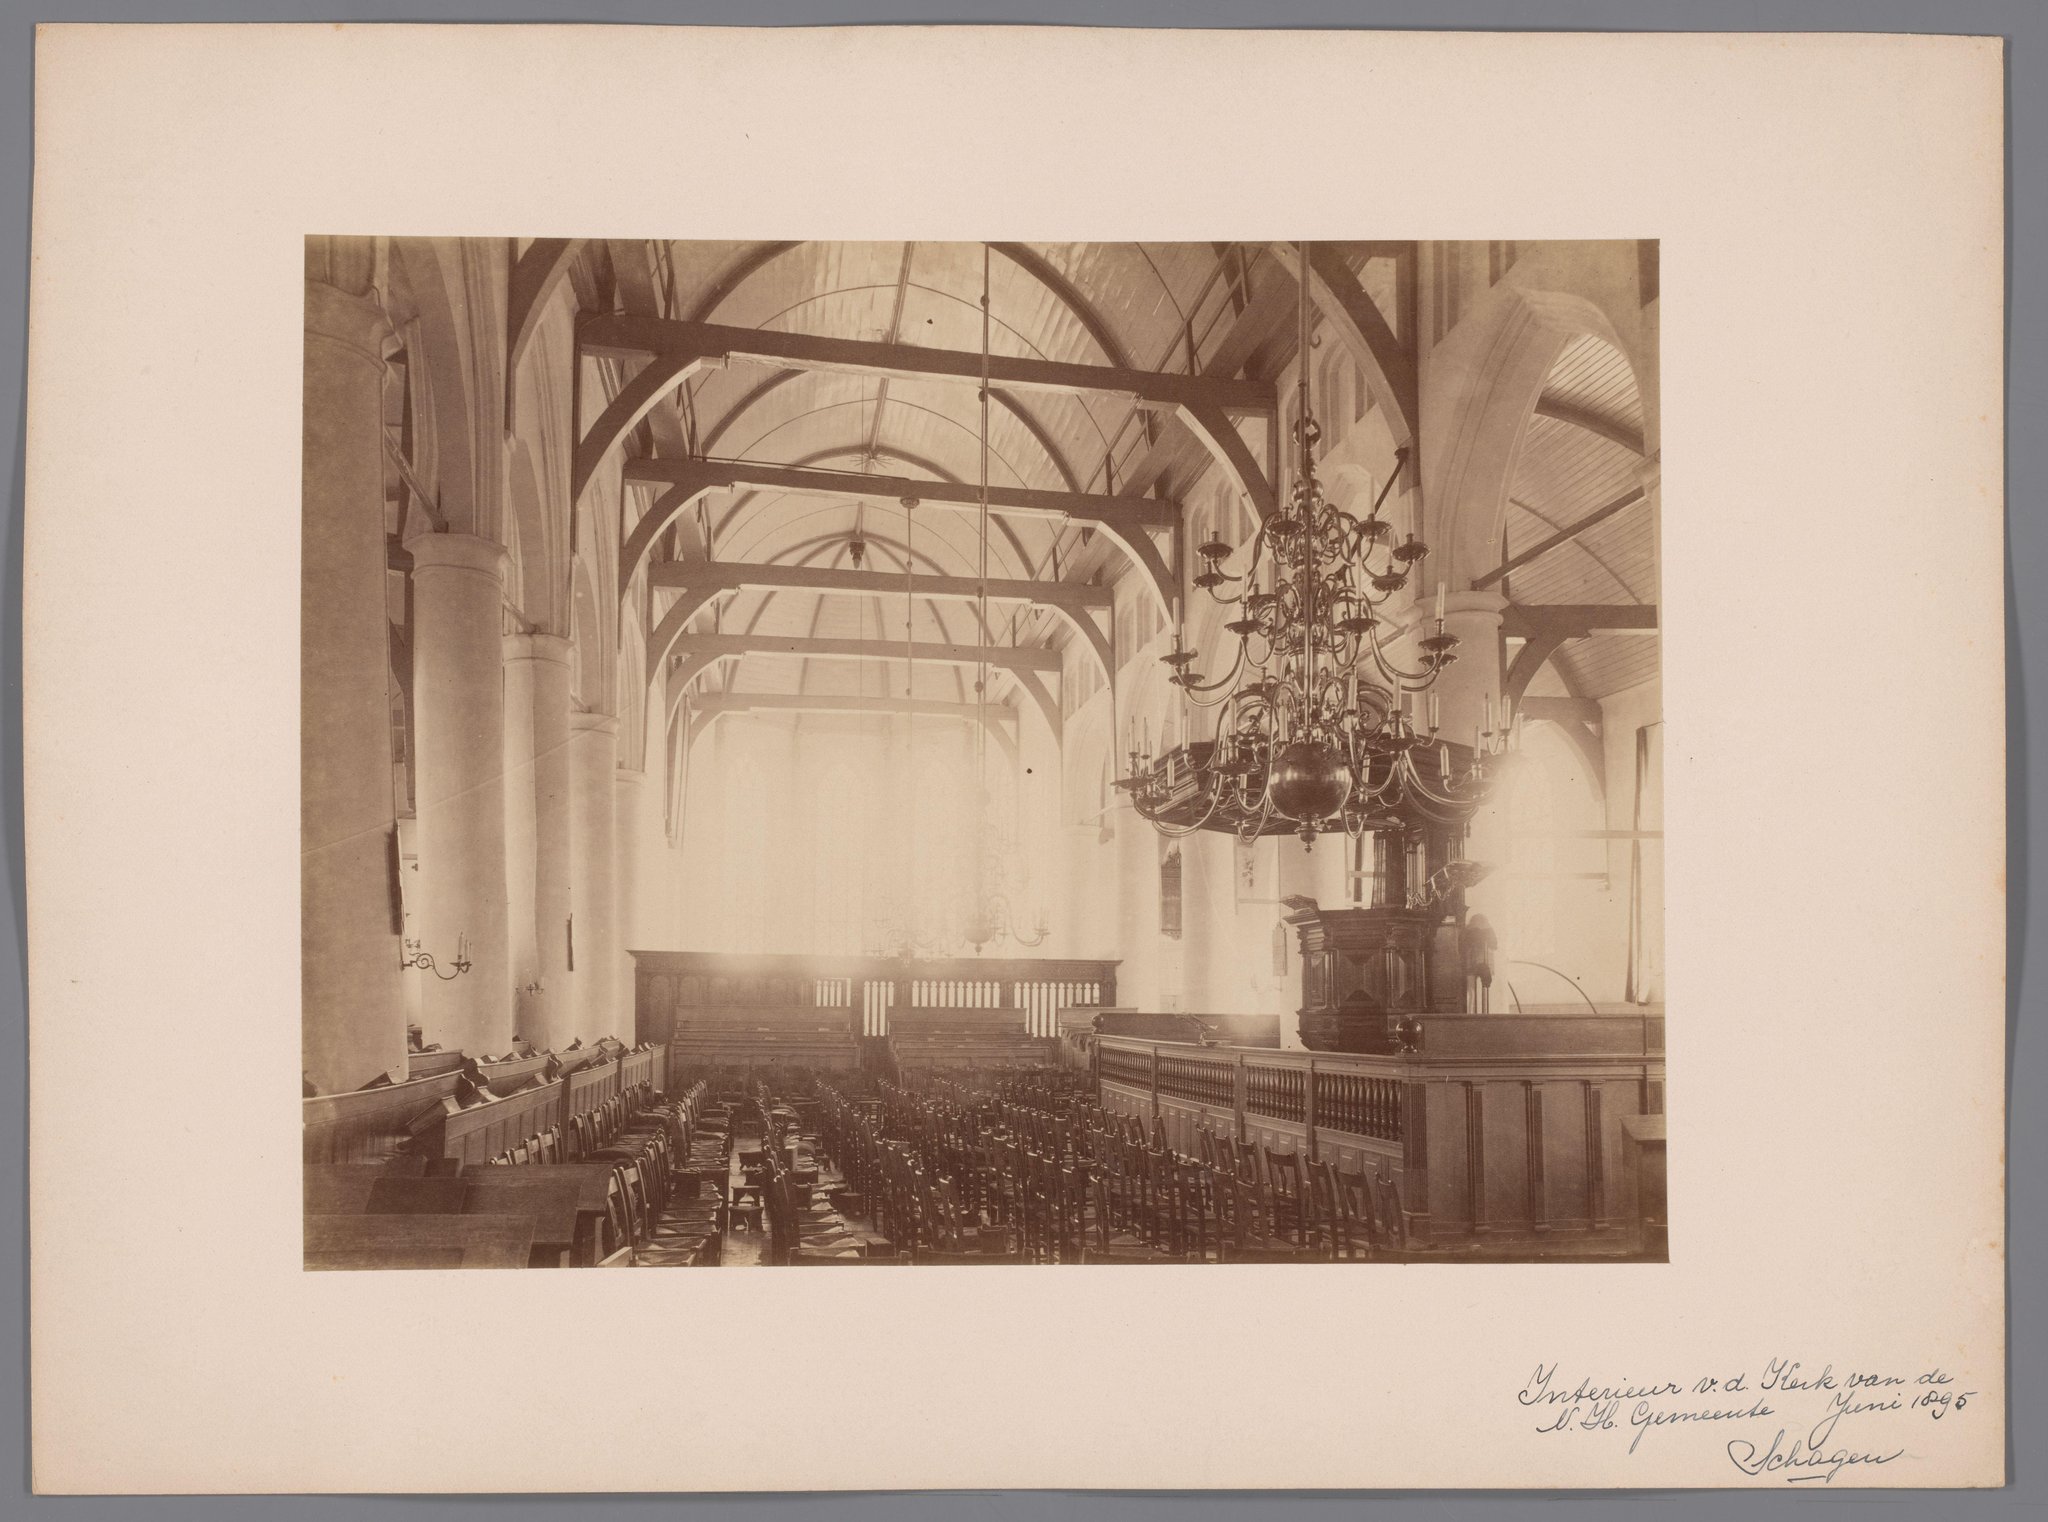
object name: photograph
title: Interieur van de Nederlands-Hervormde Kerk te Schagen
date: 1895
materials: cardboard, photographic support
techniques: albumen print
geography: schagen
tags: interior of church, schagen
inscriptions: annotation: ‘Schagen (N.H.)/ De kerk v/d NH gemeente van binnen/ Juni 1895’, annotation: ‘Interieur v.d. Kerk van de N.H. gemeente Juni 1895/ Schagen’